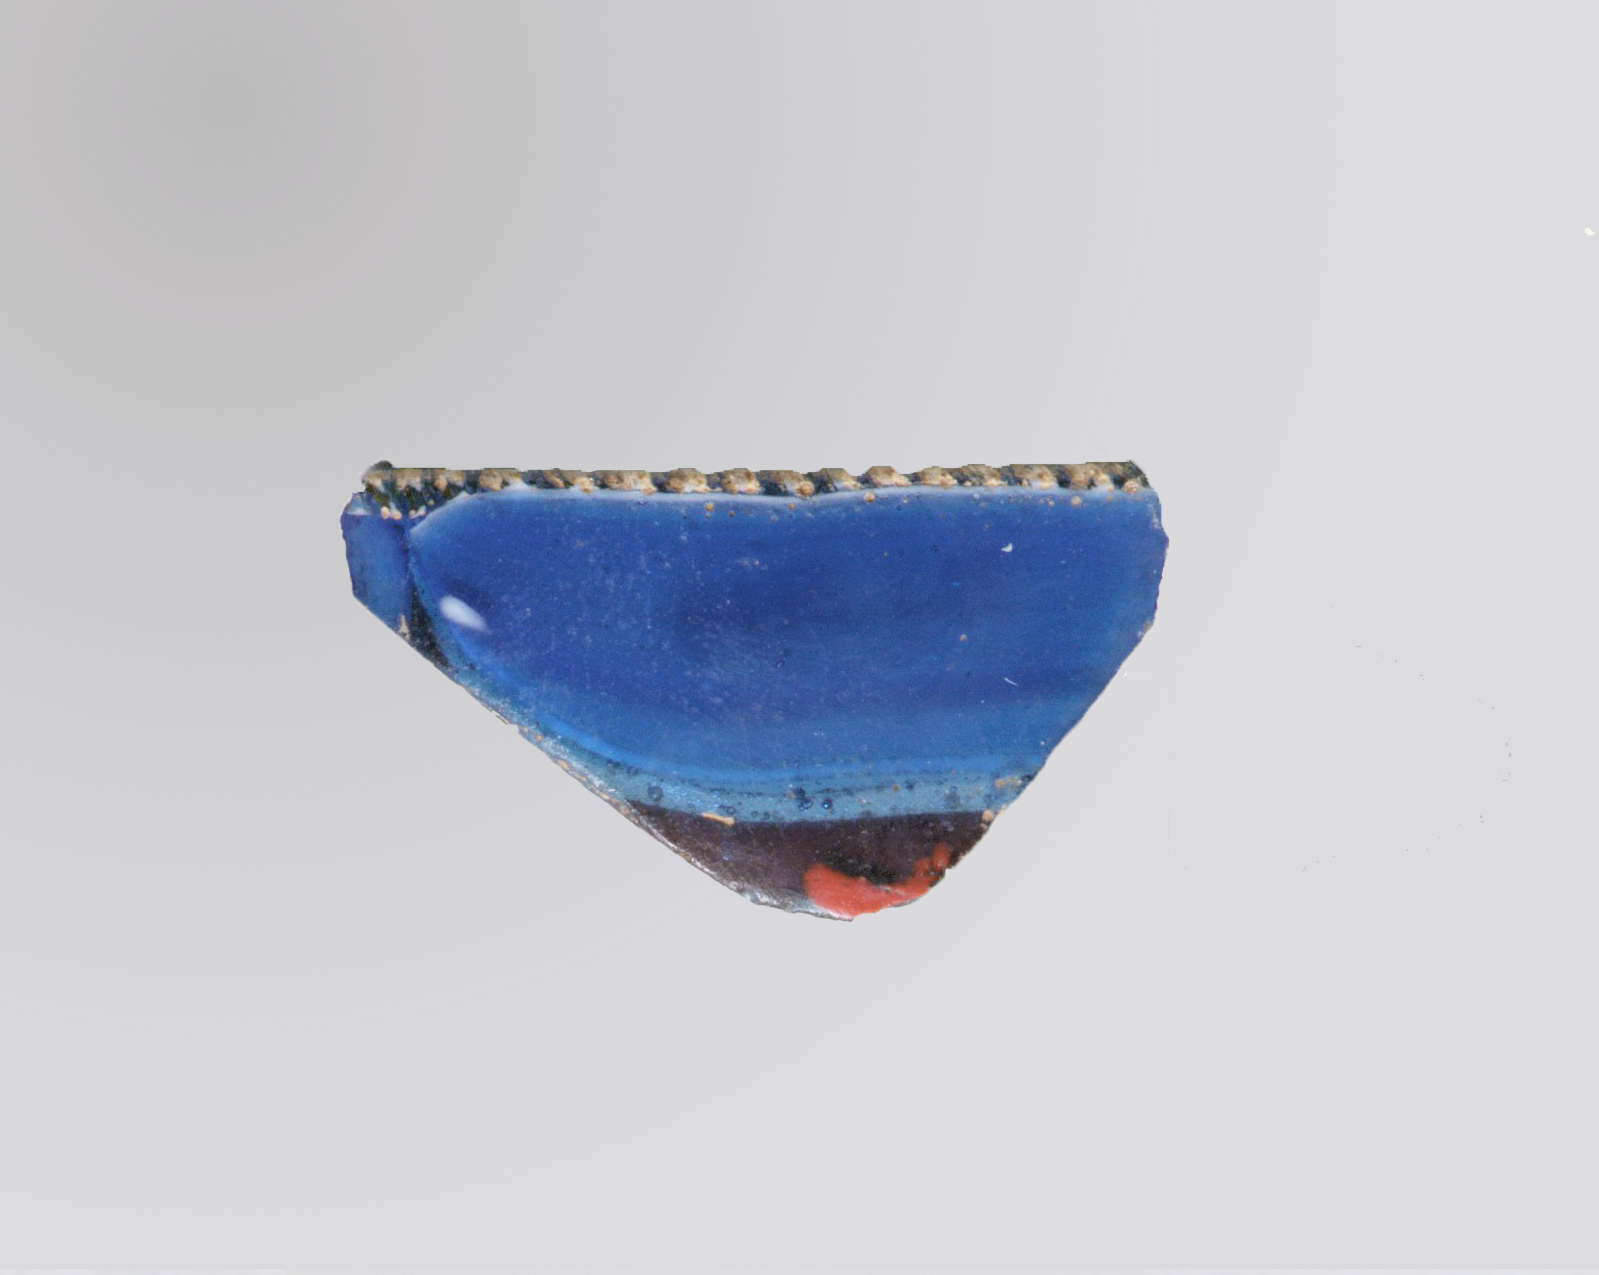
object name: fragment, meandering strip mosaic bowl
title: Glass mosaic meandering-strip bowl fragment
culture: roman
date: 34 BCE-33 CE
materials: glass